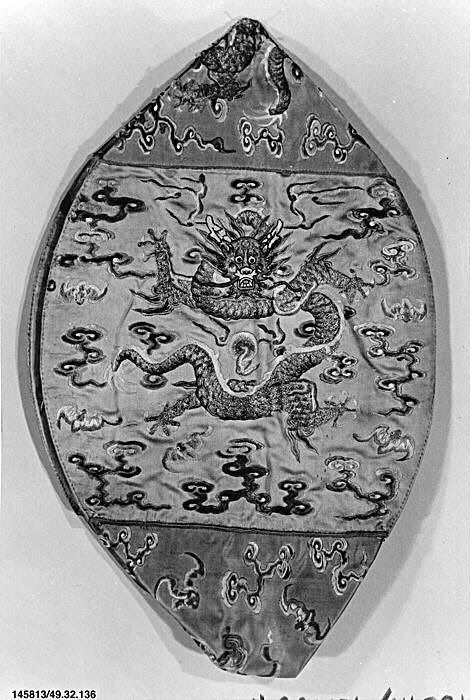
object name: cushion cover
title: Cushion Cover for Imperial Arm Pillow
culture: chinese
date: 1736-1795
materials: metal thread, silk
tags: dragons